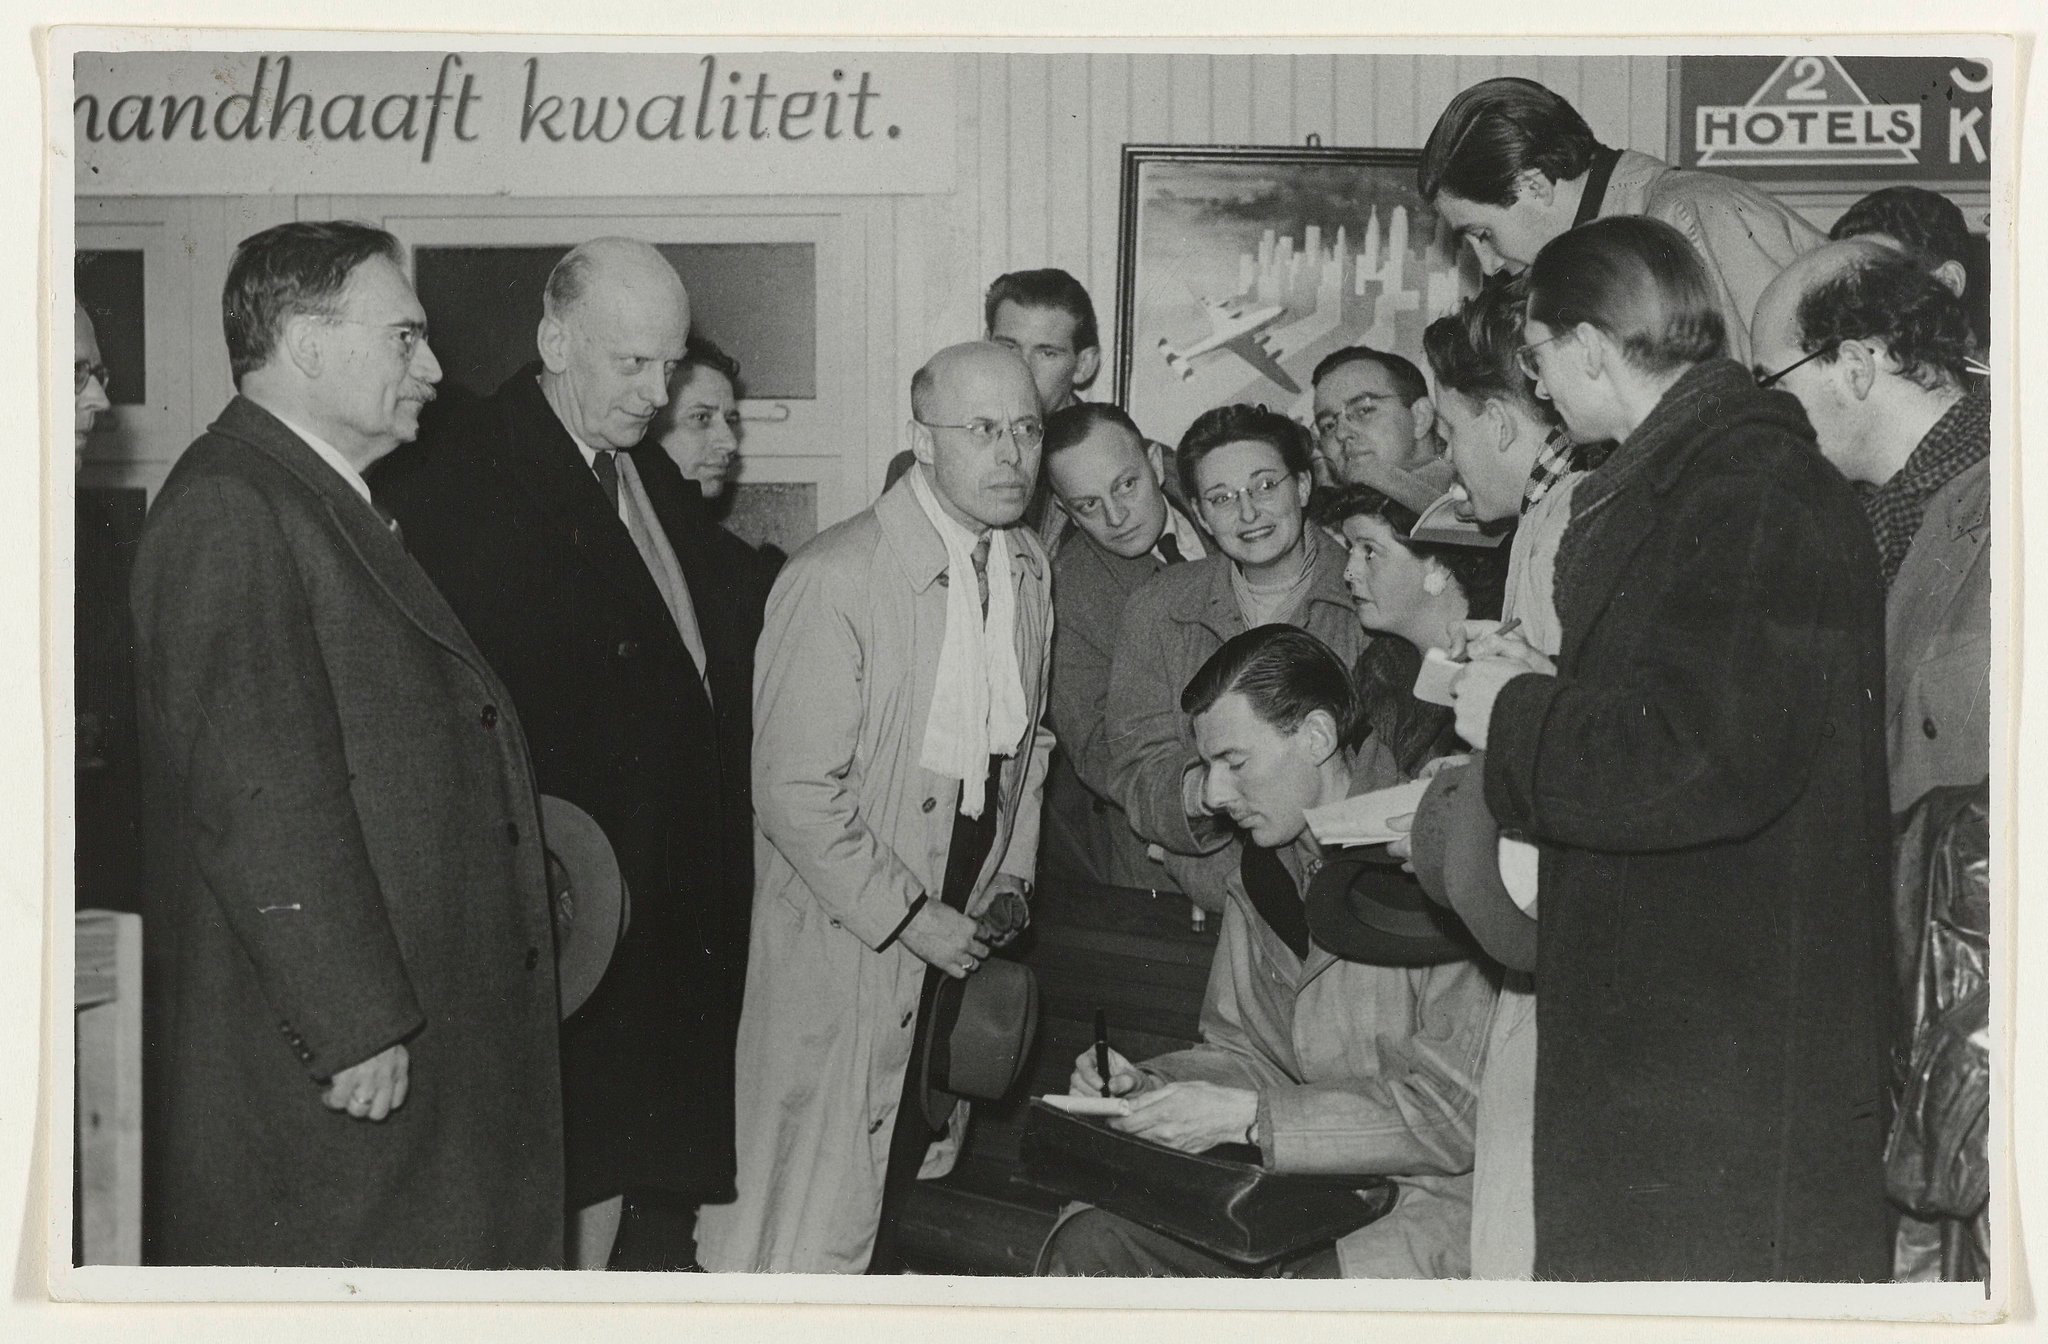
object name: documentary photograph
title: Drees terug uit Indonesië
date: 1948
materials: photographic support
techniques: photography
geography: schiphol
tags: louis jozeph maria beel, utrecht, the hague, amsterdam, willem drees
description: Op Schiphol zijn zojuist de minister-president Beel,vice premier en min. van Sociale zaken Drees en Jonkman, minister voor Overzeese gebiedsdelen aangekomen uit Indonesië. Beel wordt geïnterviewd.Zij waren in Indonesië voor overleg met de Indonesische Republikeinen.